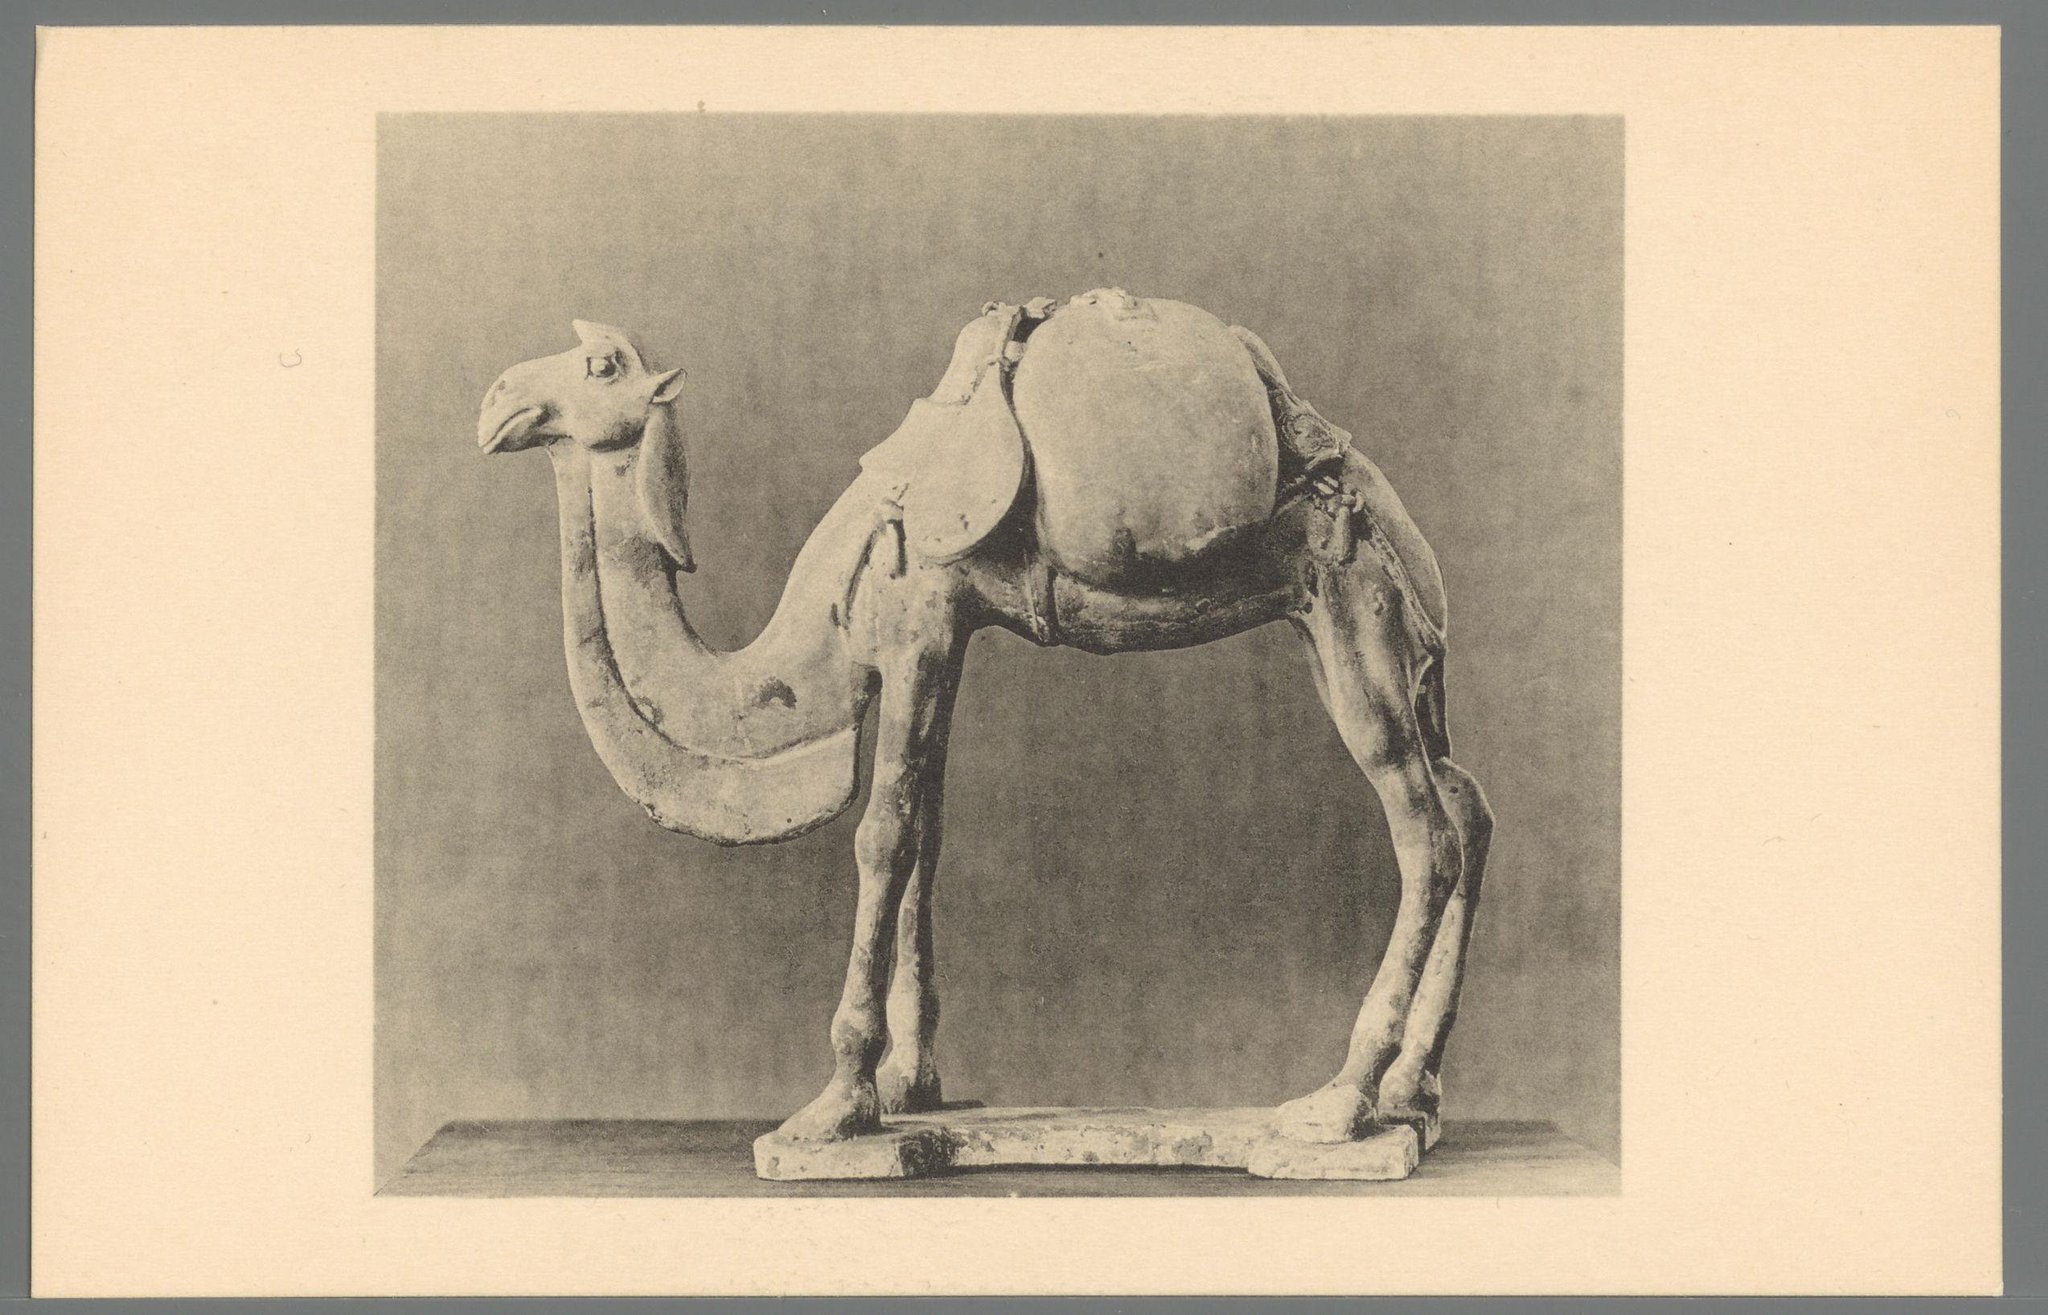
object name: ansichtkaart, prentbriefkaart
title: Chinese Pottery, T'ang Dynasty. Camel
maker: Anonymous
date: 1920-1950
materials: cardboard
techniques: photograph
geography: cambridge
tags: hoofed animals: camel, sculpture